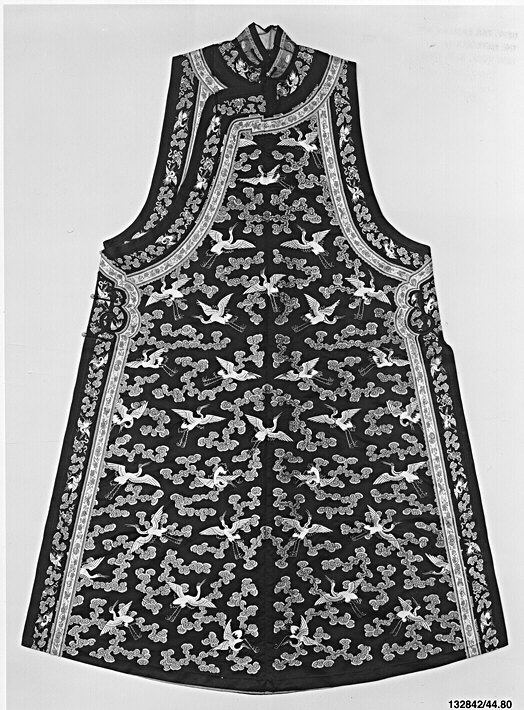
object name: woman's birthday overvest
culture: chinese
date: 1801-1900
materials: silk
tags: cranes